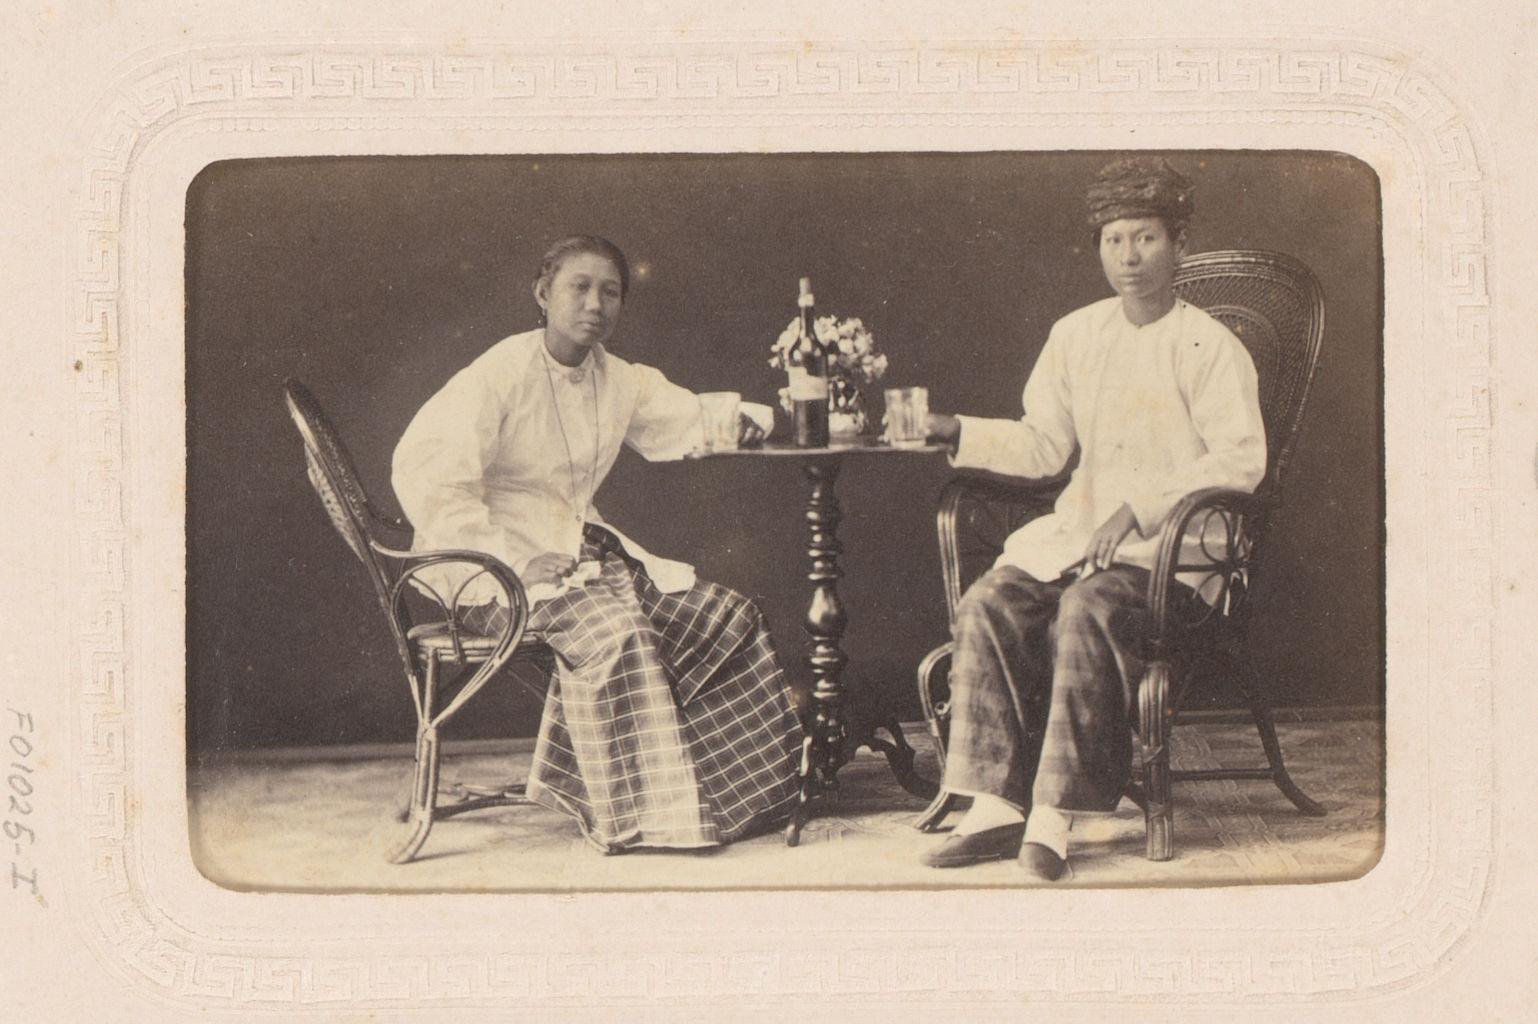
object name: photograph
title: Drie Maleisische vrouwen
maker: Anonymous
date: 1850-1880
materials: cardboard, photographic support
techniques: albumen print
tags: adult woman, sitting on the ground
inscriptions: annotation: ‘Drei Maleysche Frauen’, number: ‘8’